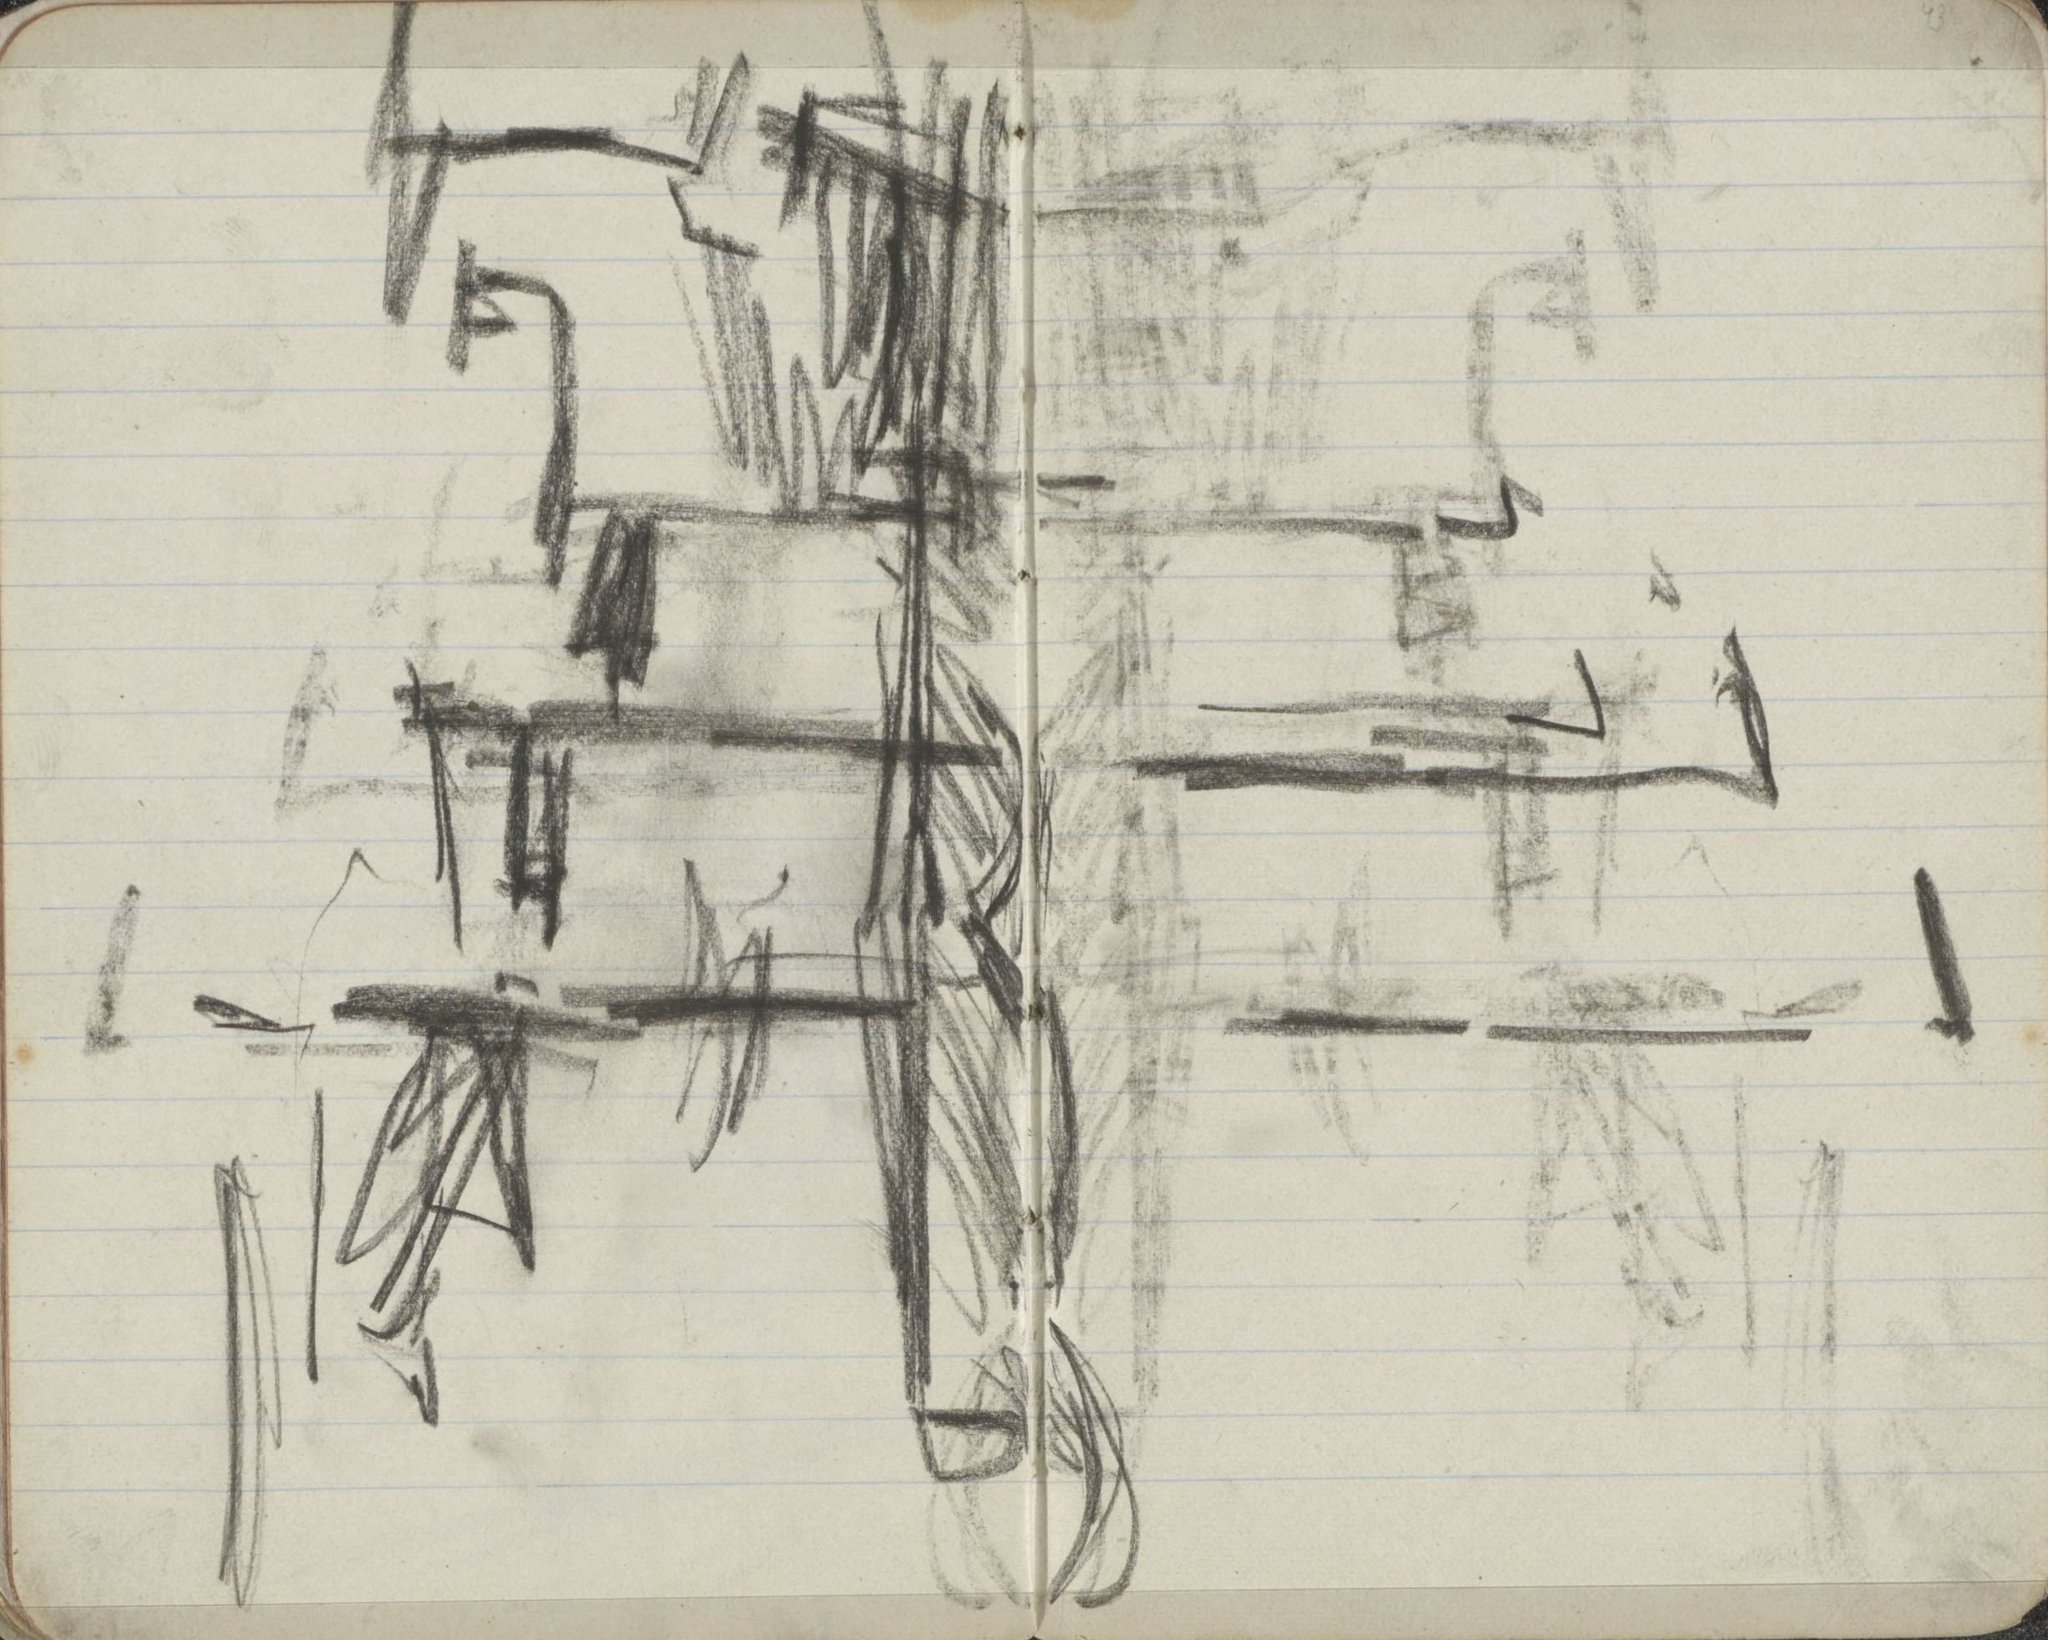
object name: sketchbook leaf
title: Studie, mogelijk een stadsgezicht met schepen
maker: george hendrik breitner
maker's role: draughtsman, painter, print maker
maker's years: 1857-1923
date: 1893-1894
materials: chalk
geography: amsterdam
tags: ships (in general), canals, waters (in city), amsterdam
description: Pagina 42 en pagina 43 uit een schetsboek met 36 bladen.